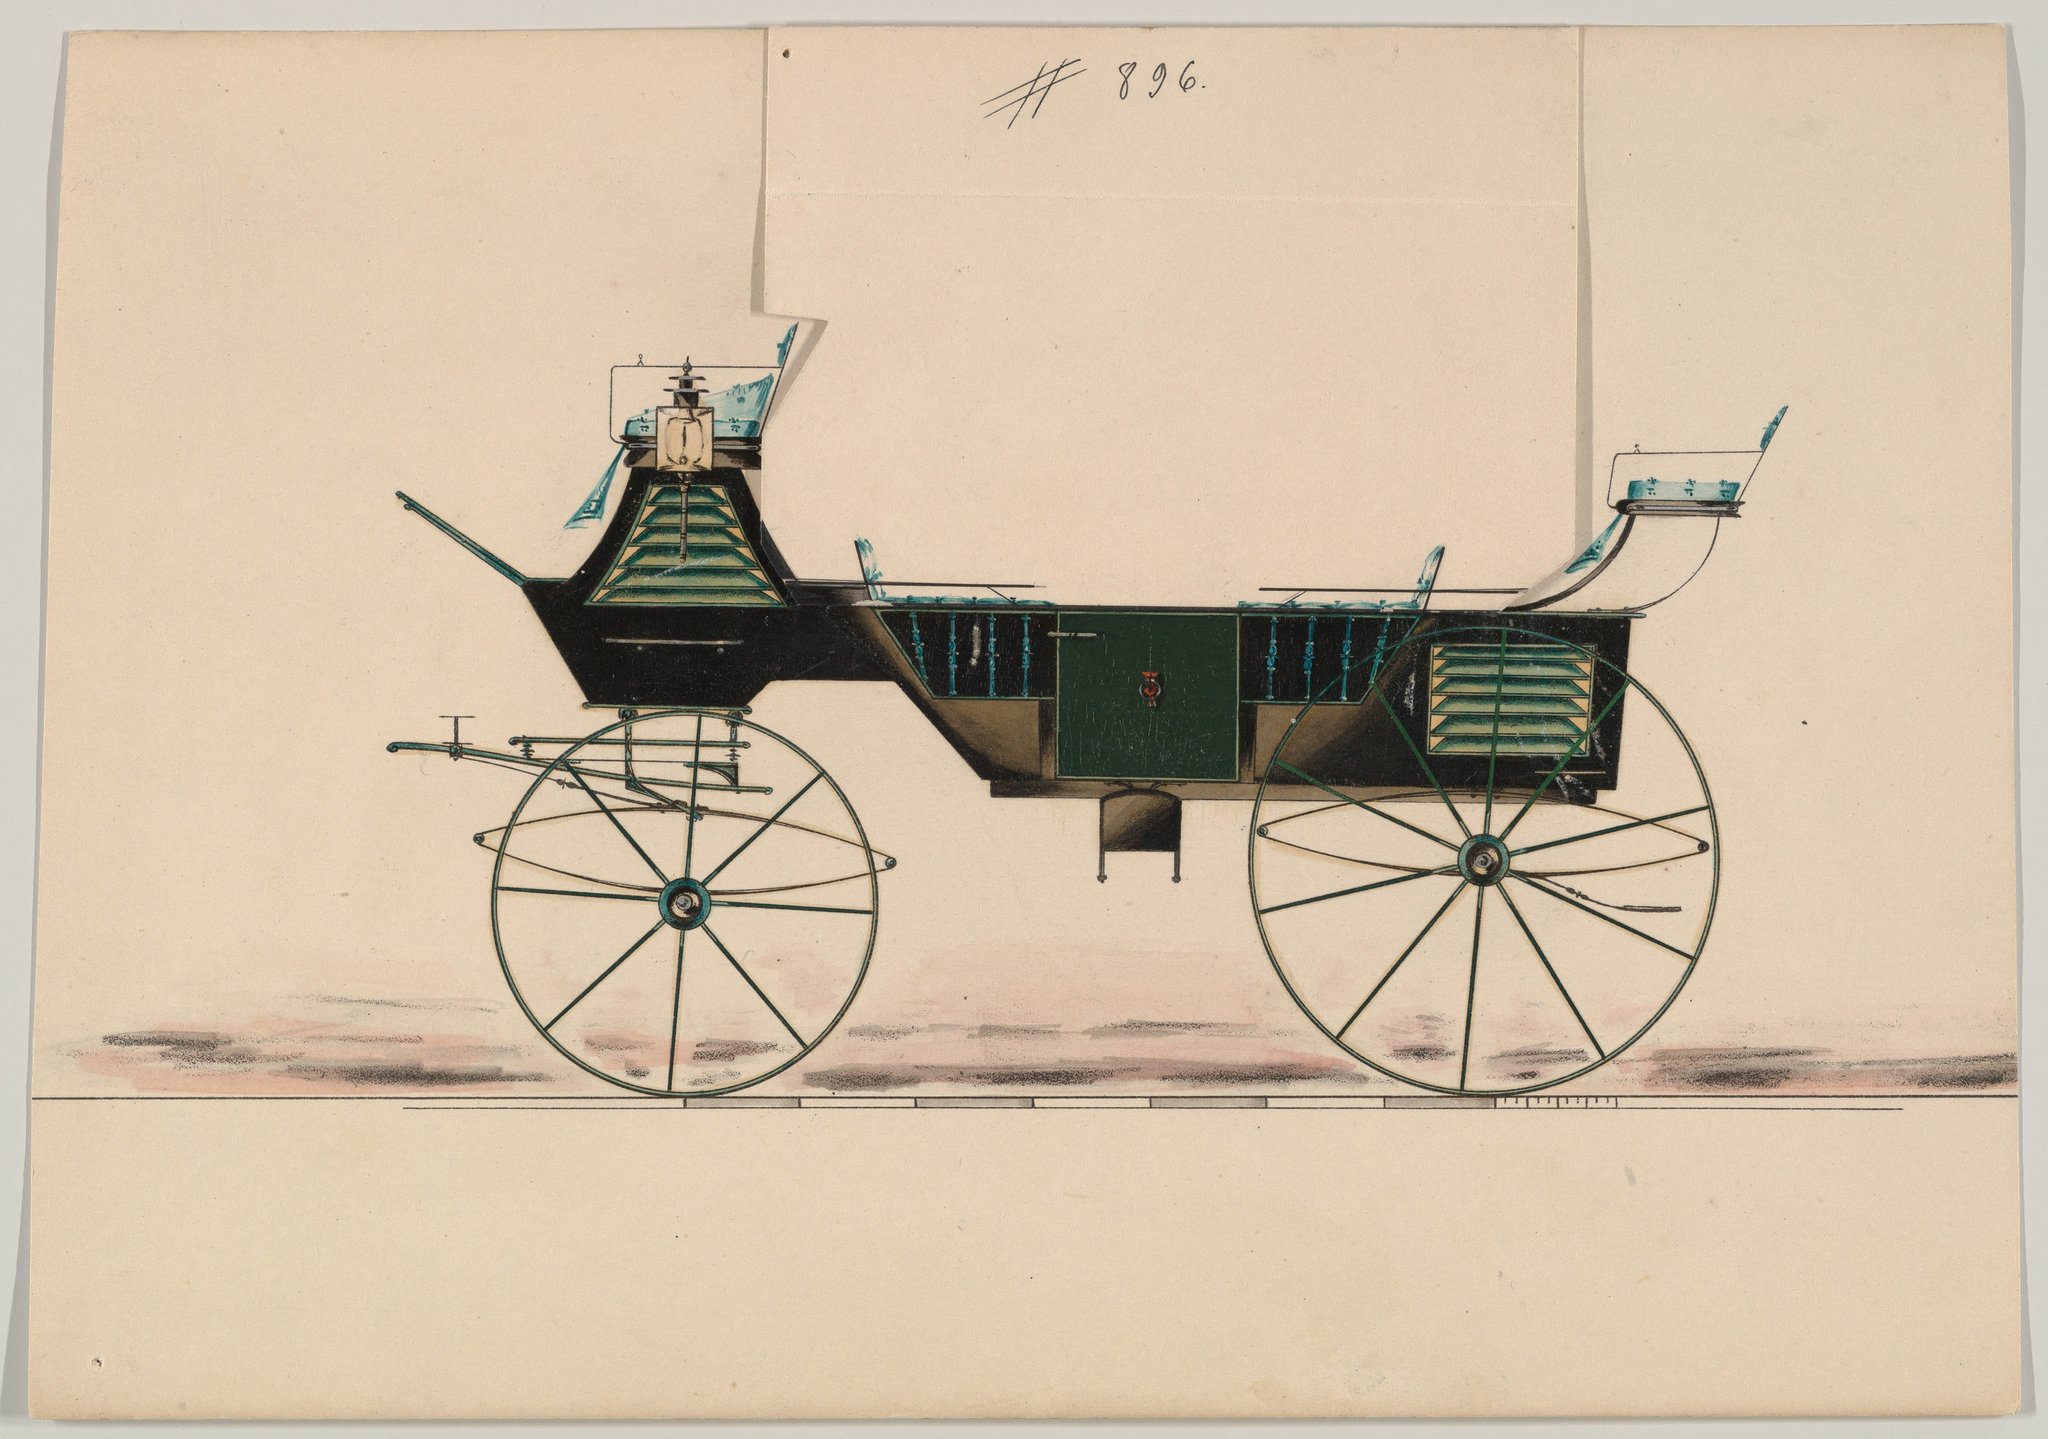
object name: drawing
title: Stage #896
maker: brewster & co.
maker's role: manufacturer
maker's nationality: american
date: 1850-1870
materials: gouache, gum arabic, ink, watercolor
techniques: pen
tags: carriages